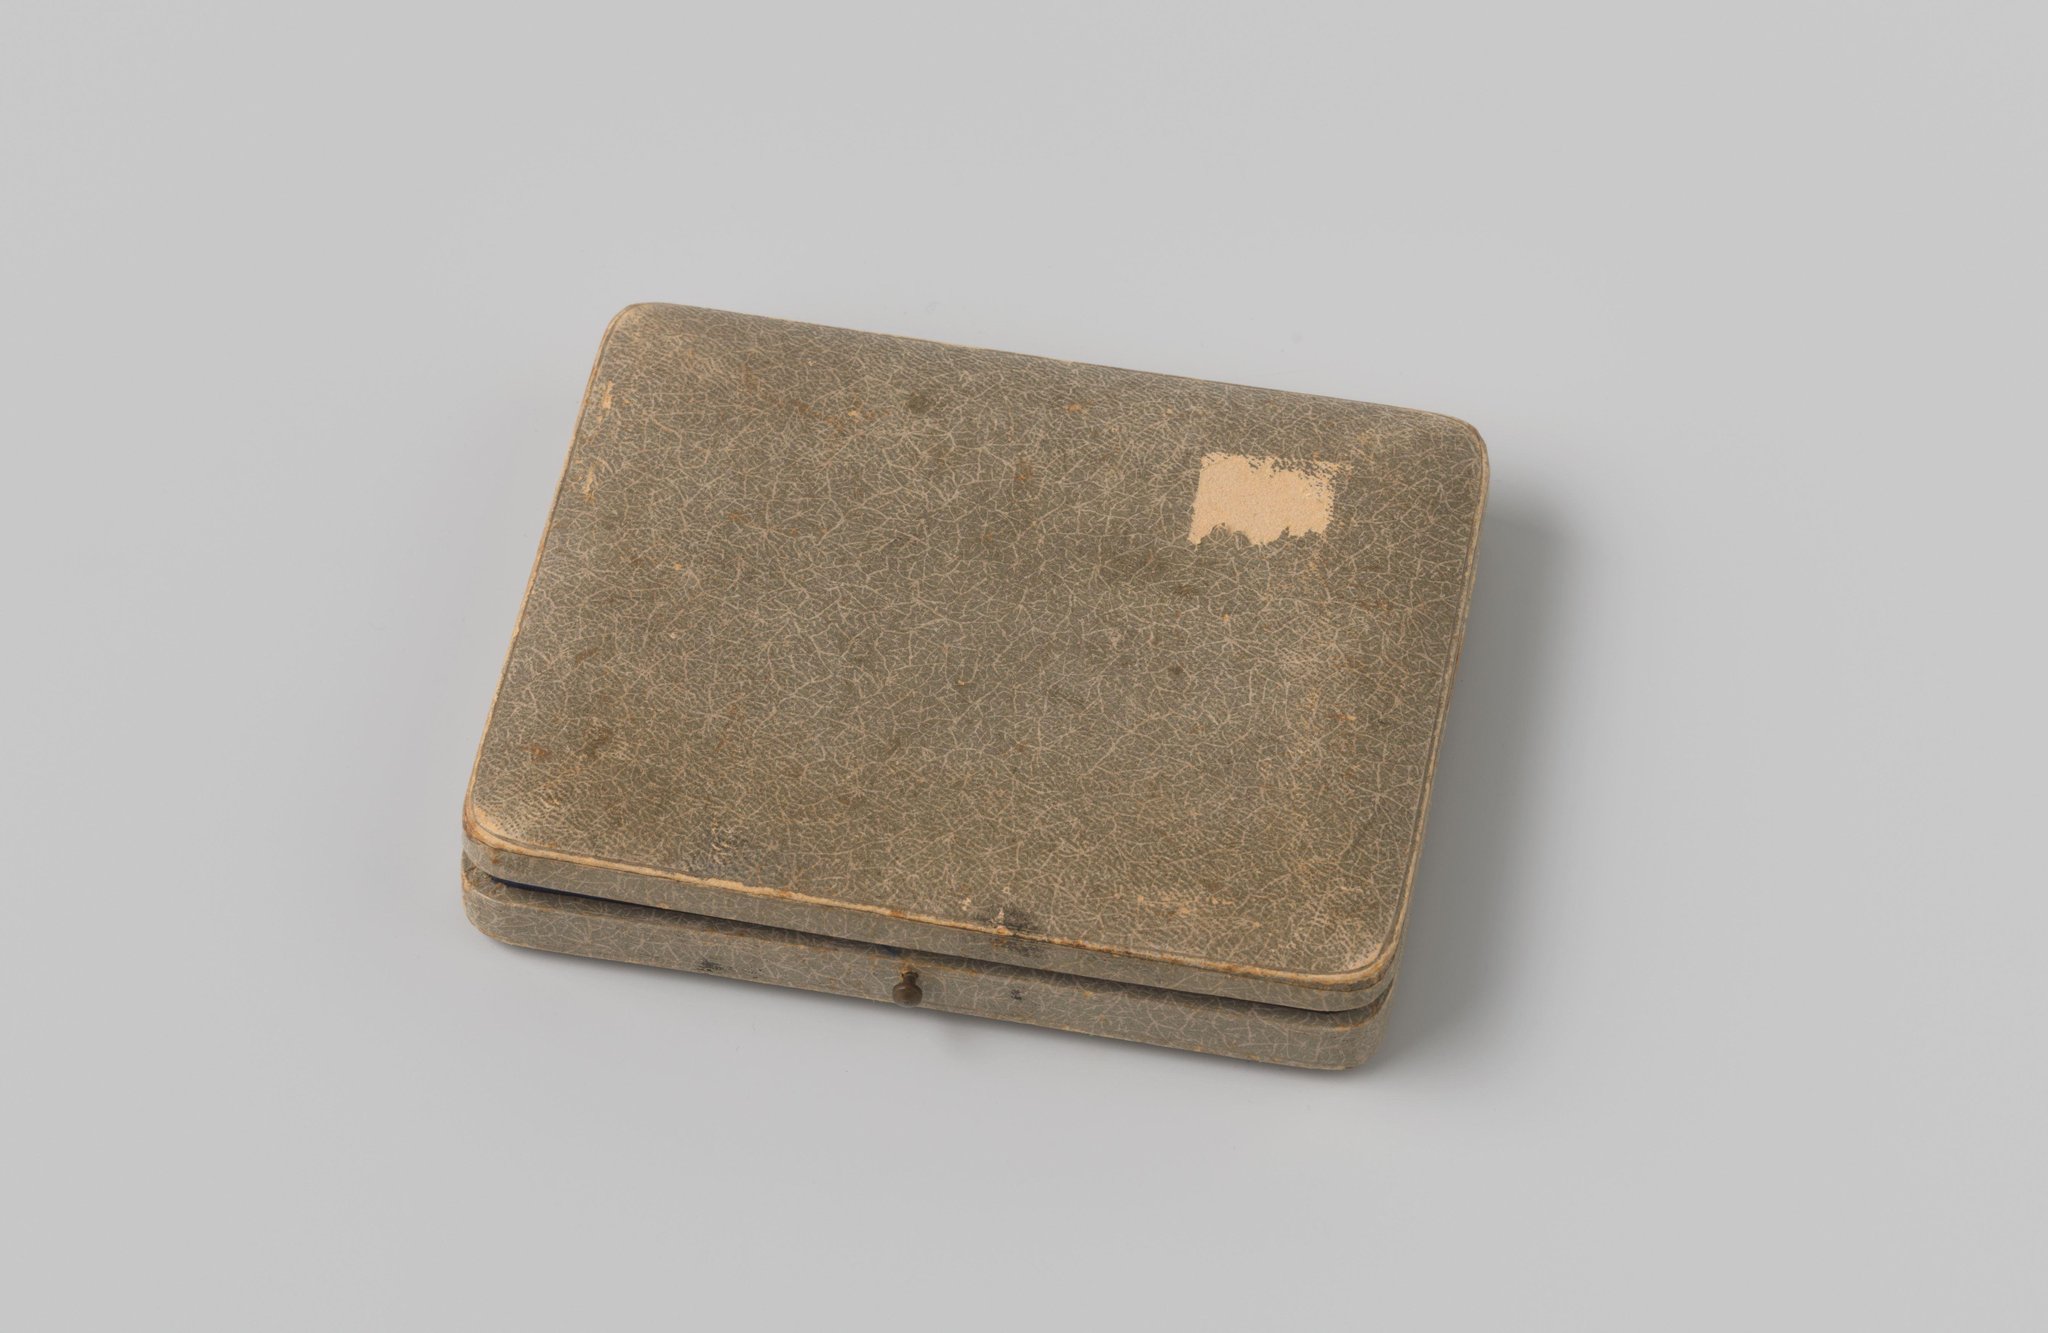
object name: box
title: Doos bij plaquette van de XVIIIe Interparlementaire Vredesconferentie Den Haag, 1913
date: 1913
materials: cardboard, silk, velvet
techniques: printing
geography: utrecht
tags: the hague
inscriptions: inscription: ‘KONINKL. UTRECHTSCHE FABRIEK VAN VAN ZILVERWERKEN VAN C.J. BEGEER HOFLEVERANCIER VAN: WIJLEN Z.M. DEN KONING H.M. DE KONINGIN H.M. DE KONINGIN MOEDER Z.K.H. DEN PRINS DER NEDERL HERTOG VAN MECKLENB. OFFIC. LEVERANCIER A.N.W.B. SEN. VET.VEND UTRECHT’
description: Rechthoekige doos met ronde hoeken met grijs papier beplakt. Aan de voorzijde een knopje. Achterzijde scharnierend middels twee scharnieren en blauwe zijden vooring. Op voering in gouden letters gekroond adres. In doos blauw fluwelen inleg.